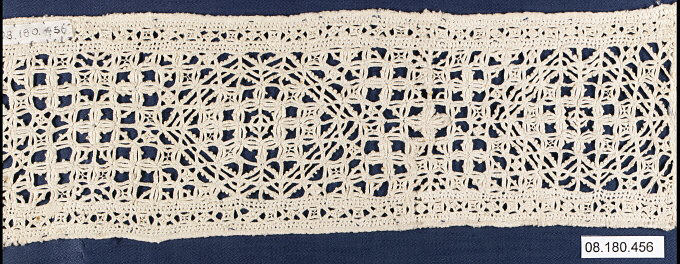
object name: border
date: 1501-1600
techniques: embroidery